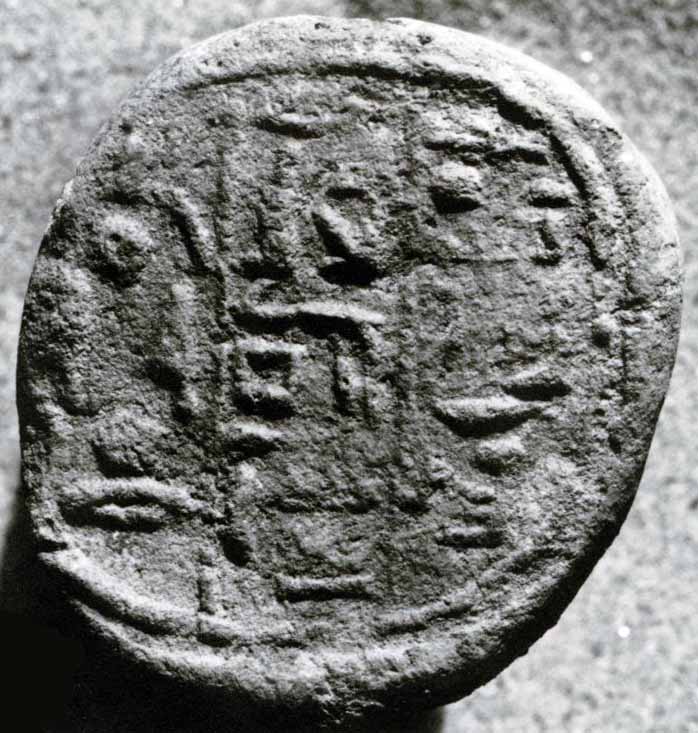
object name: cone, sobeknakht, circular impression, steward, amun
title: Funerary Cone of the Steward of Amun Sobeknakht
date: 1550-1295 BCE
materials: pottery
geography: egypt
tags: hieroglyphs